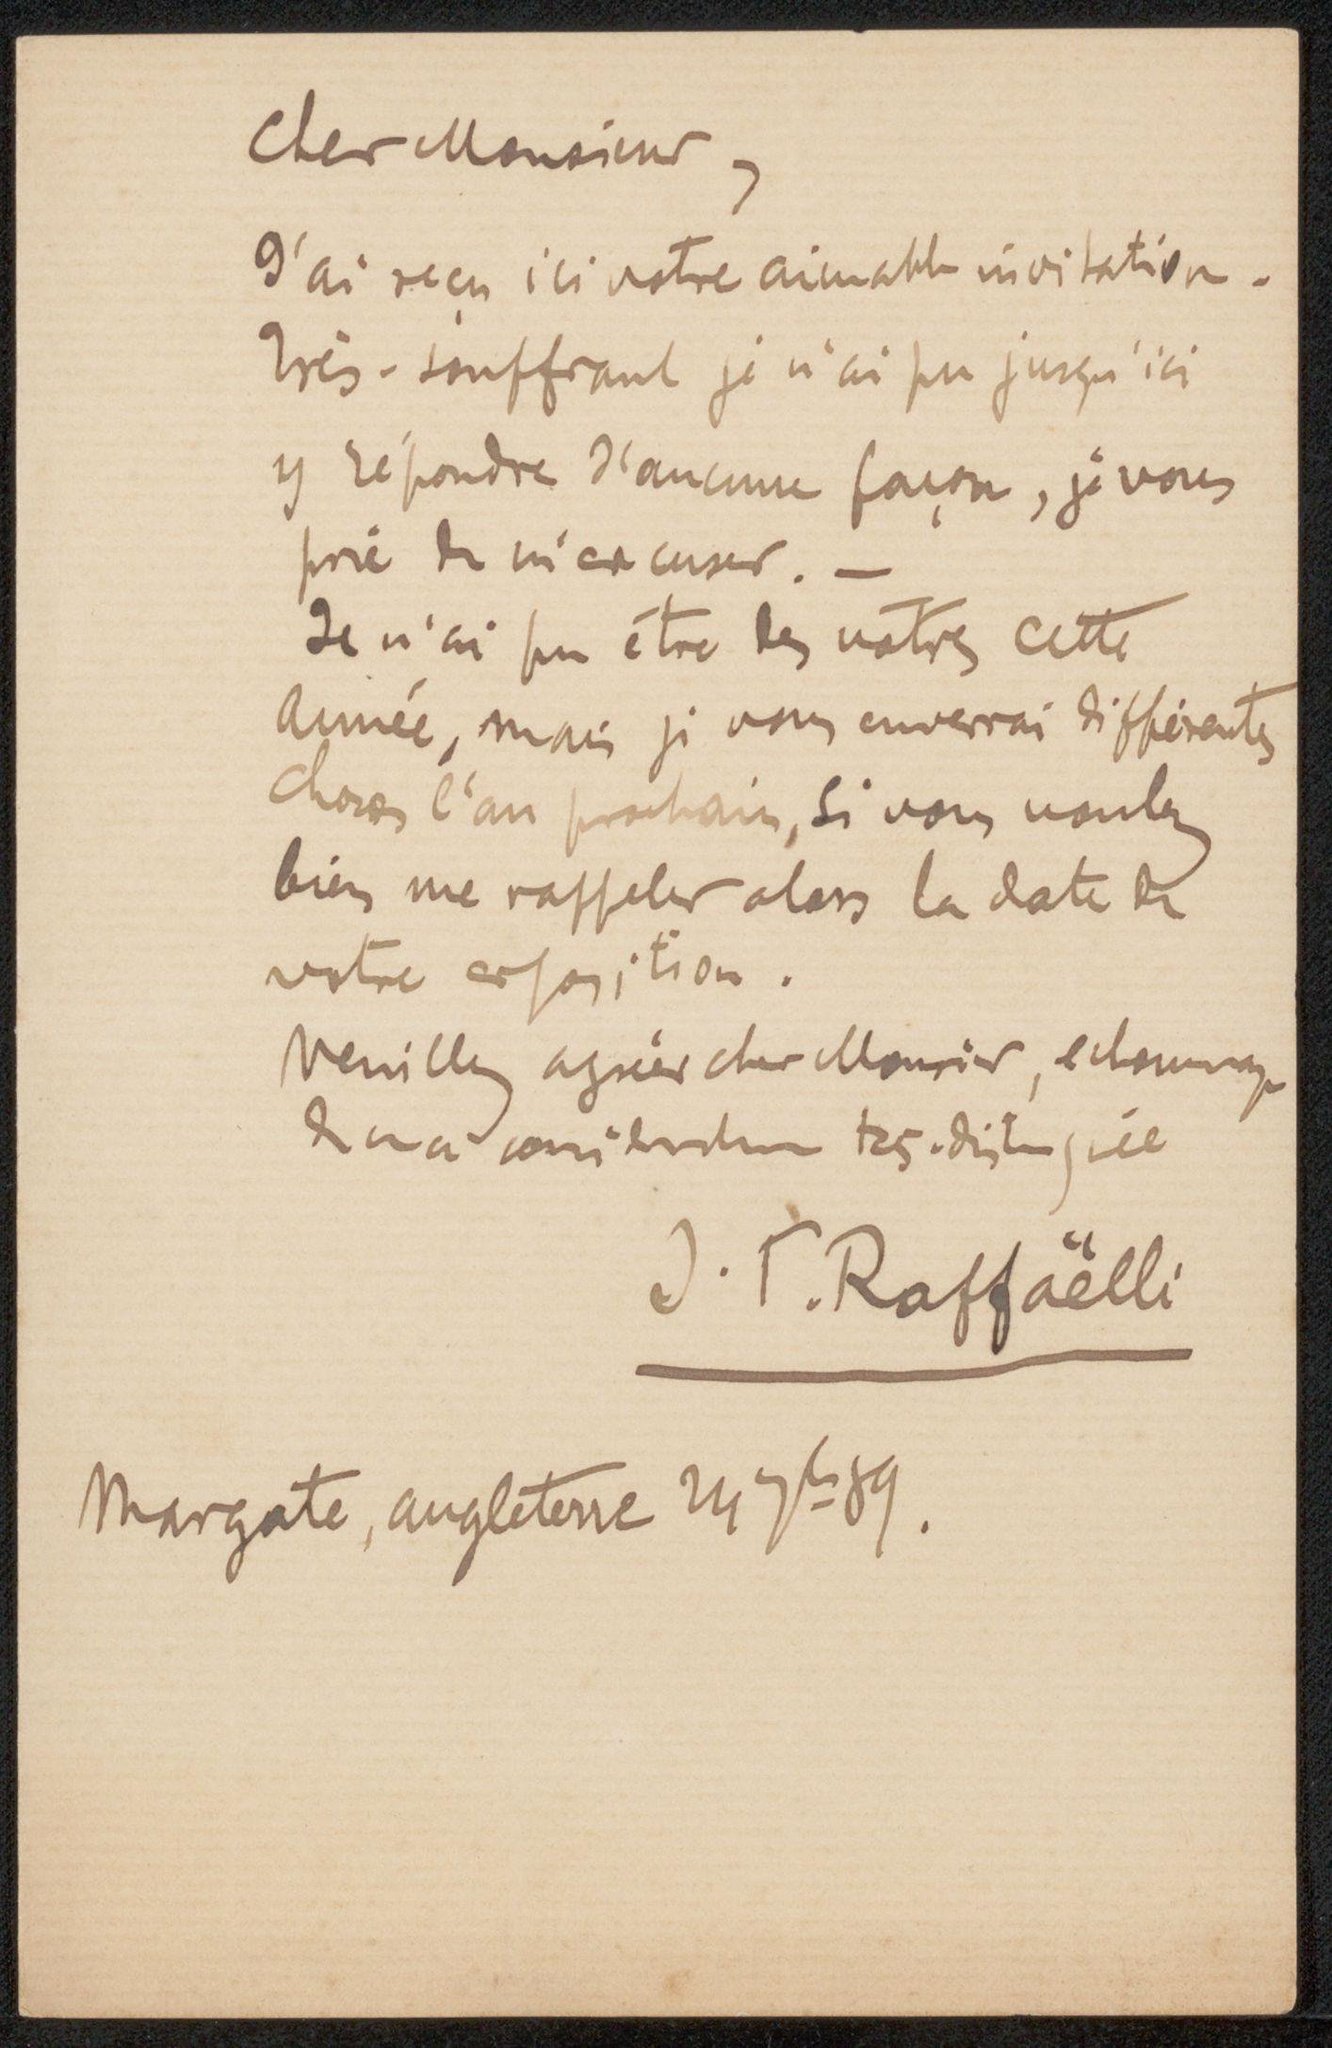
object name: letter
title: Brief aan Philip Zilcken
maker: jean françois raffaëlli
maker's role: print maker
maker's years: 1850-1924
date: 1889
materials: ink, paper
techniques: pen, writing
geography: margate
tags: the hague, painter, draughtsman, philip zilcken, exhibition ~ art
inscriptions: collector's mark: ‘RPK’